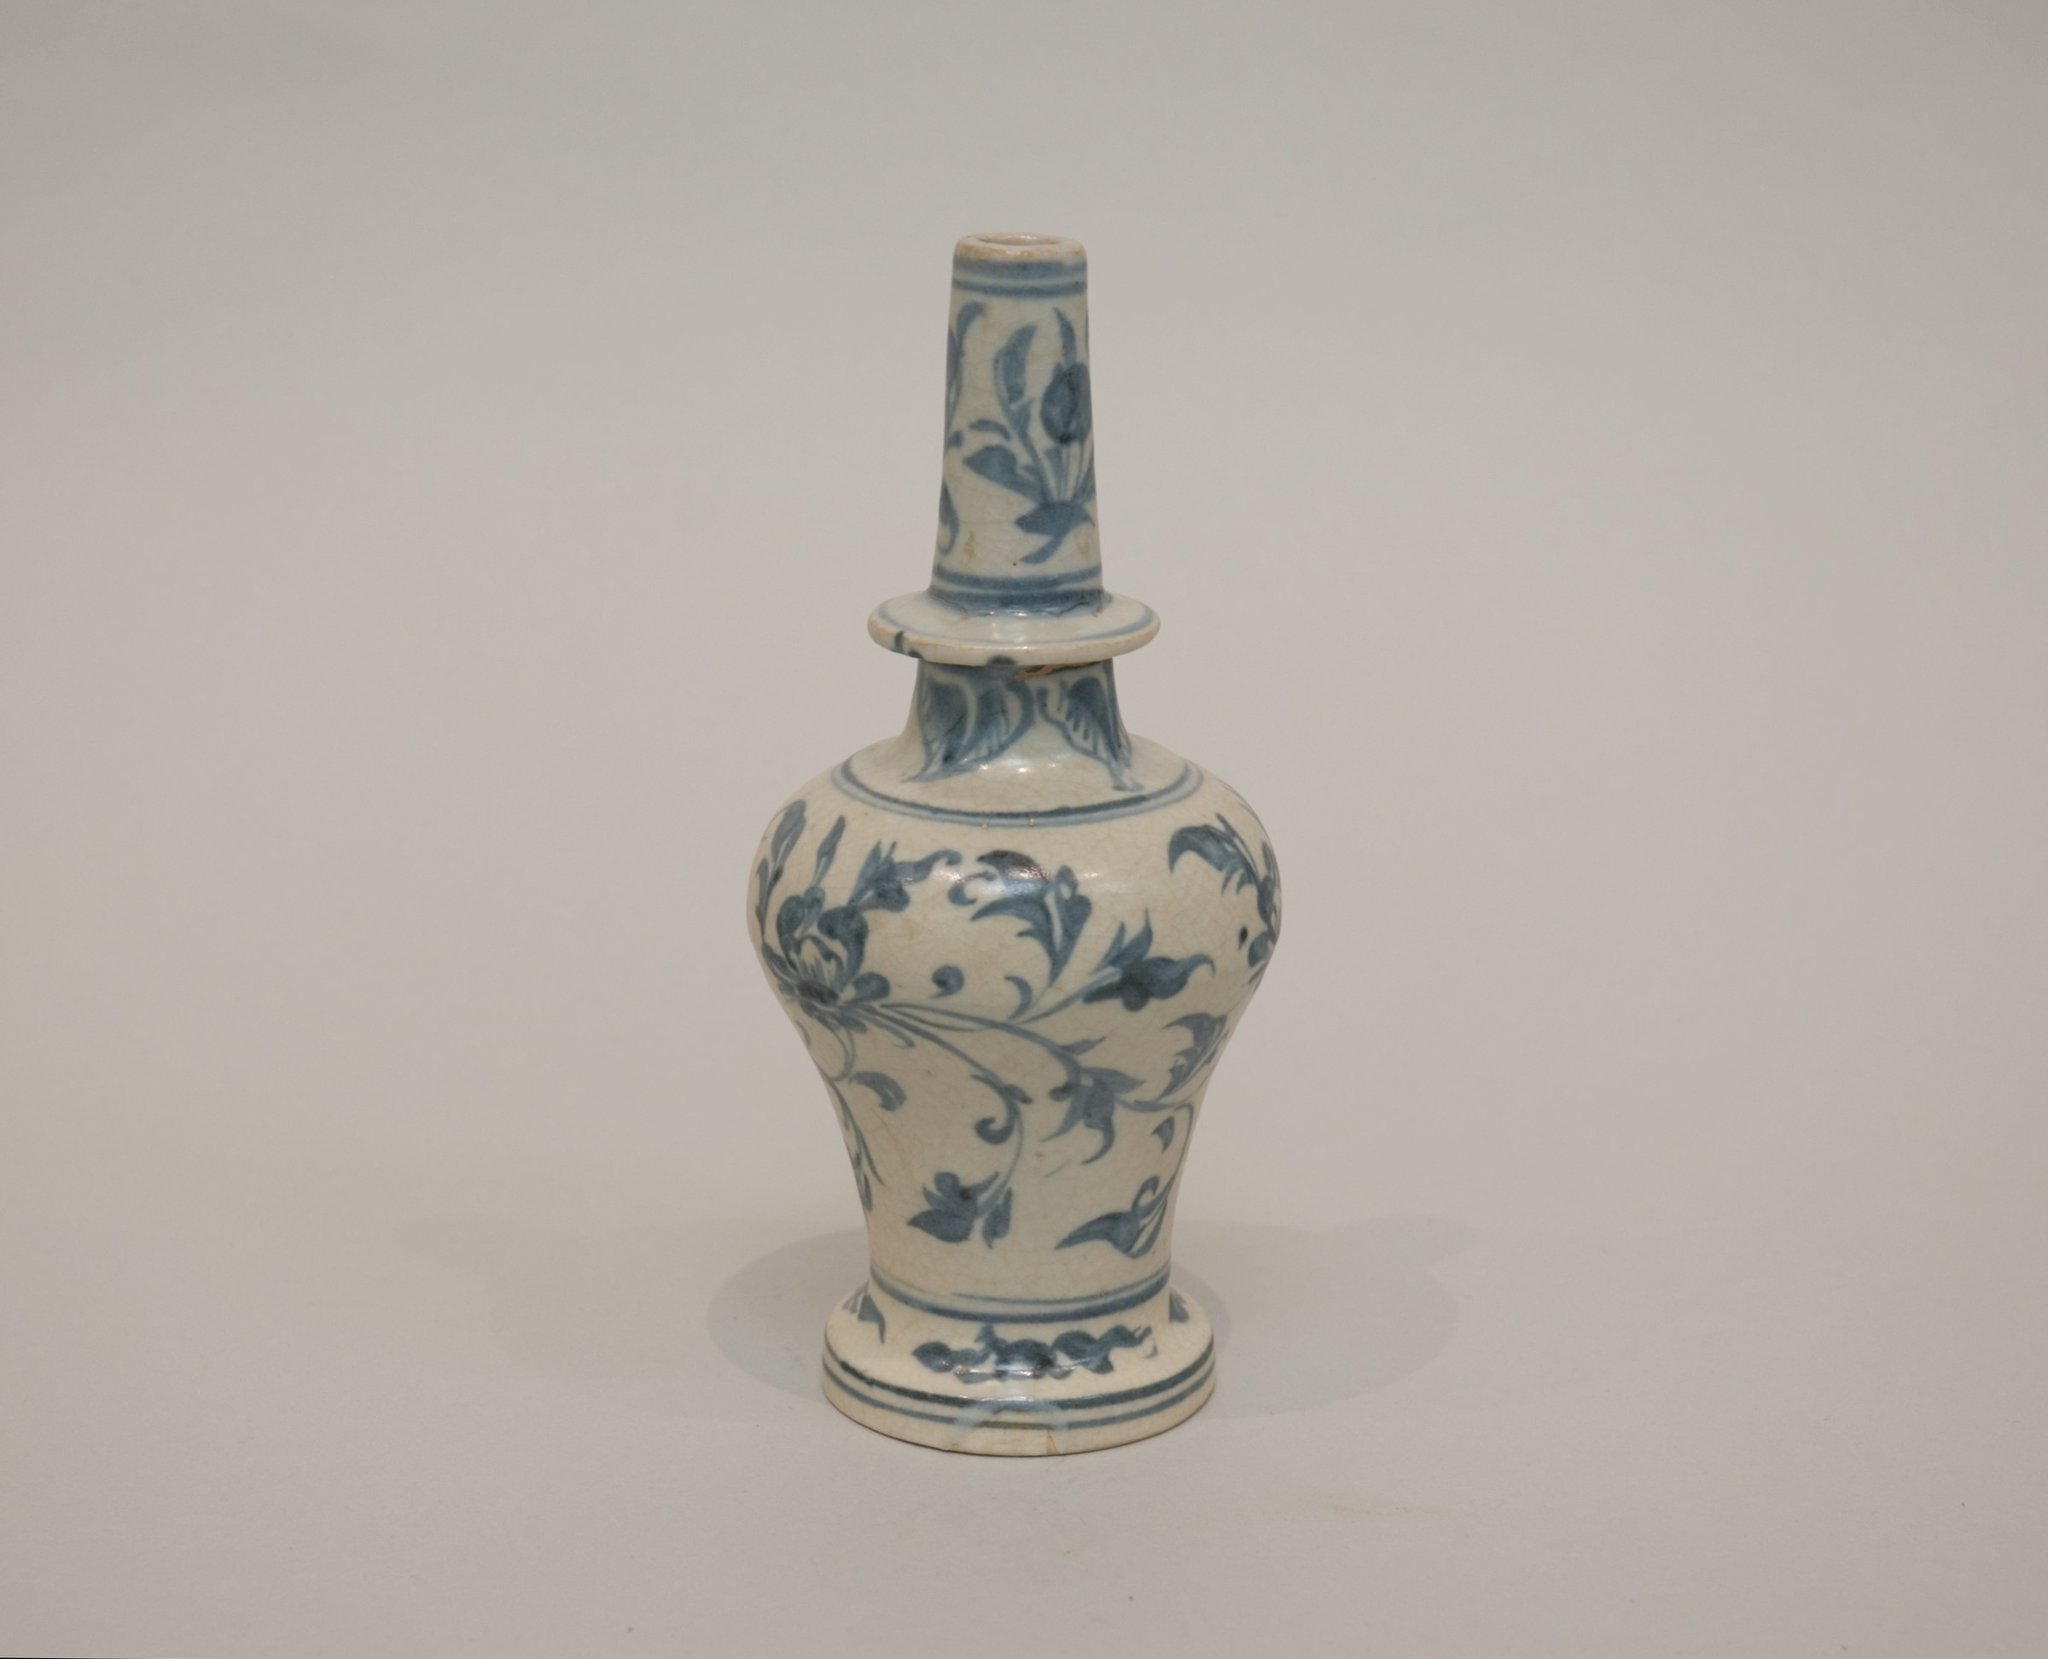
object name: sprinkler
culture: chinese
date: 1368-1644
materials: cobalt, porcelain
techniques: painting